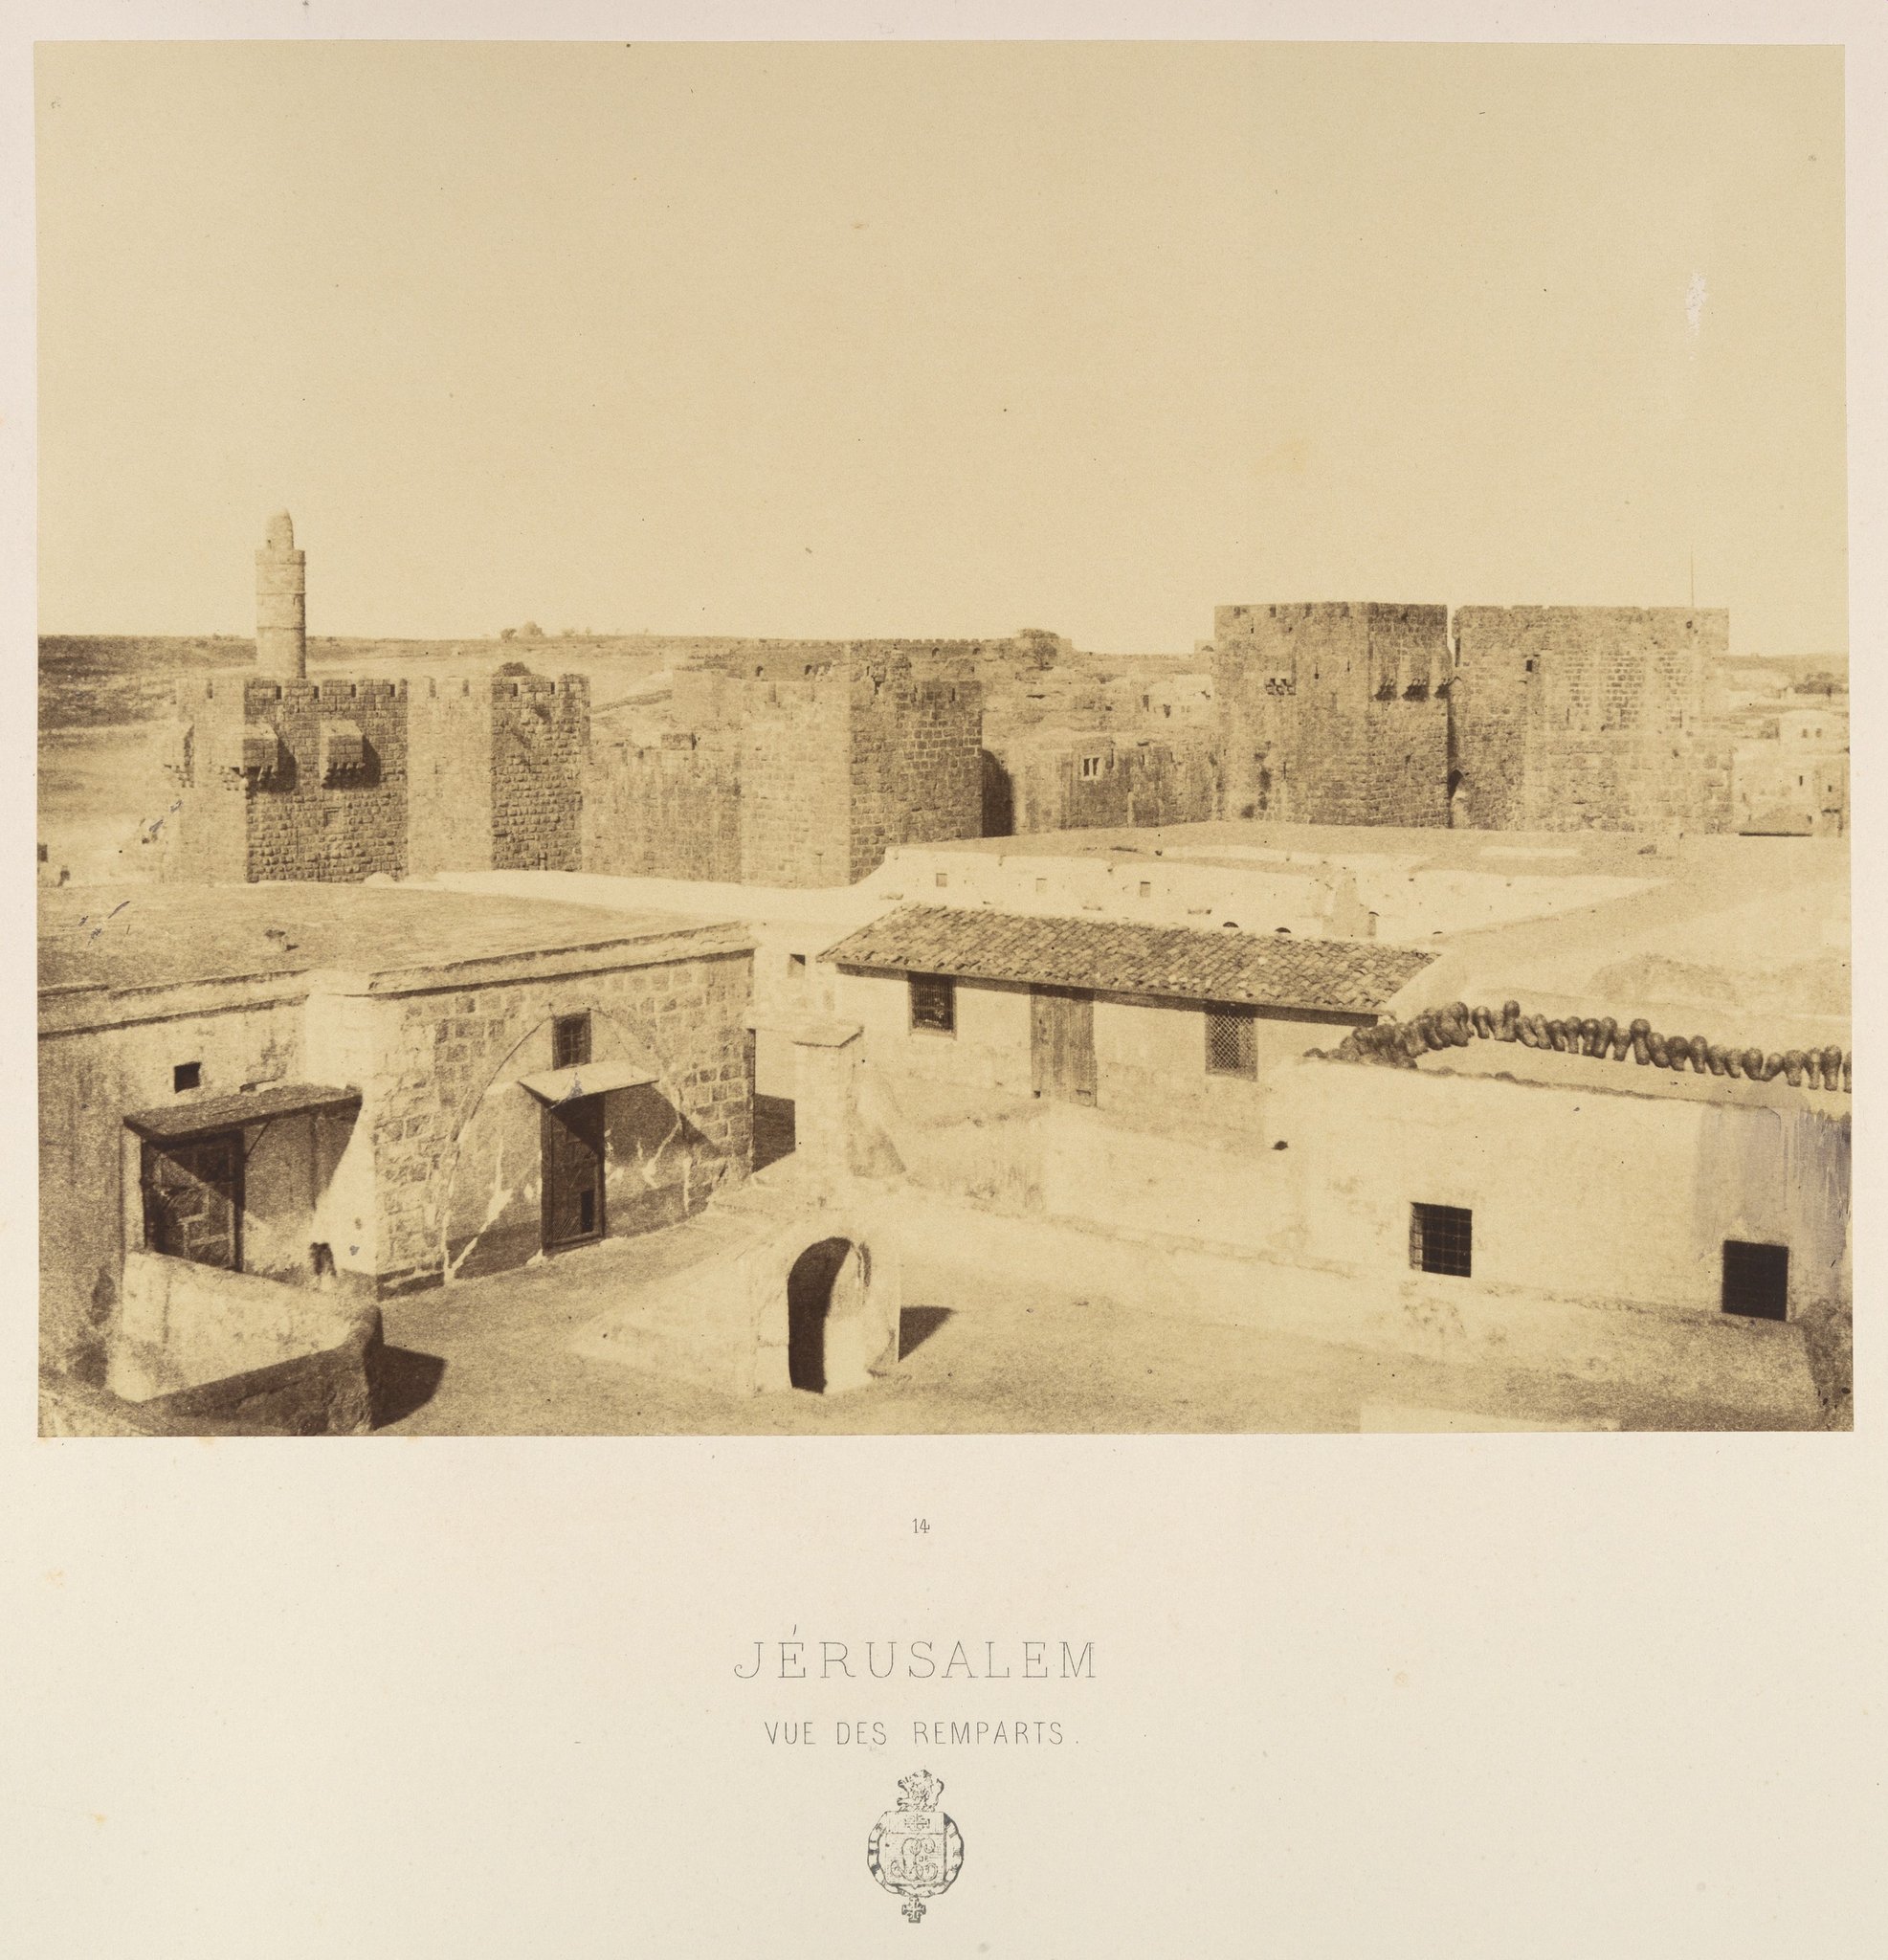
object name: photograph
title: Jérusalem. Vue des Remparts.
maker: louis de clercq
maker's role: artist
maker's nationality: french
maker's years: 1837-1901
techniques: albumen silver print, paper negative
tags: architecture,buildings